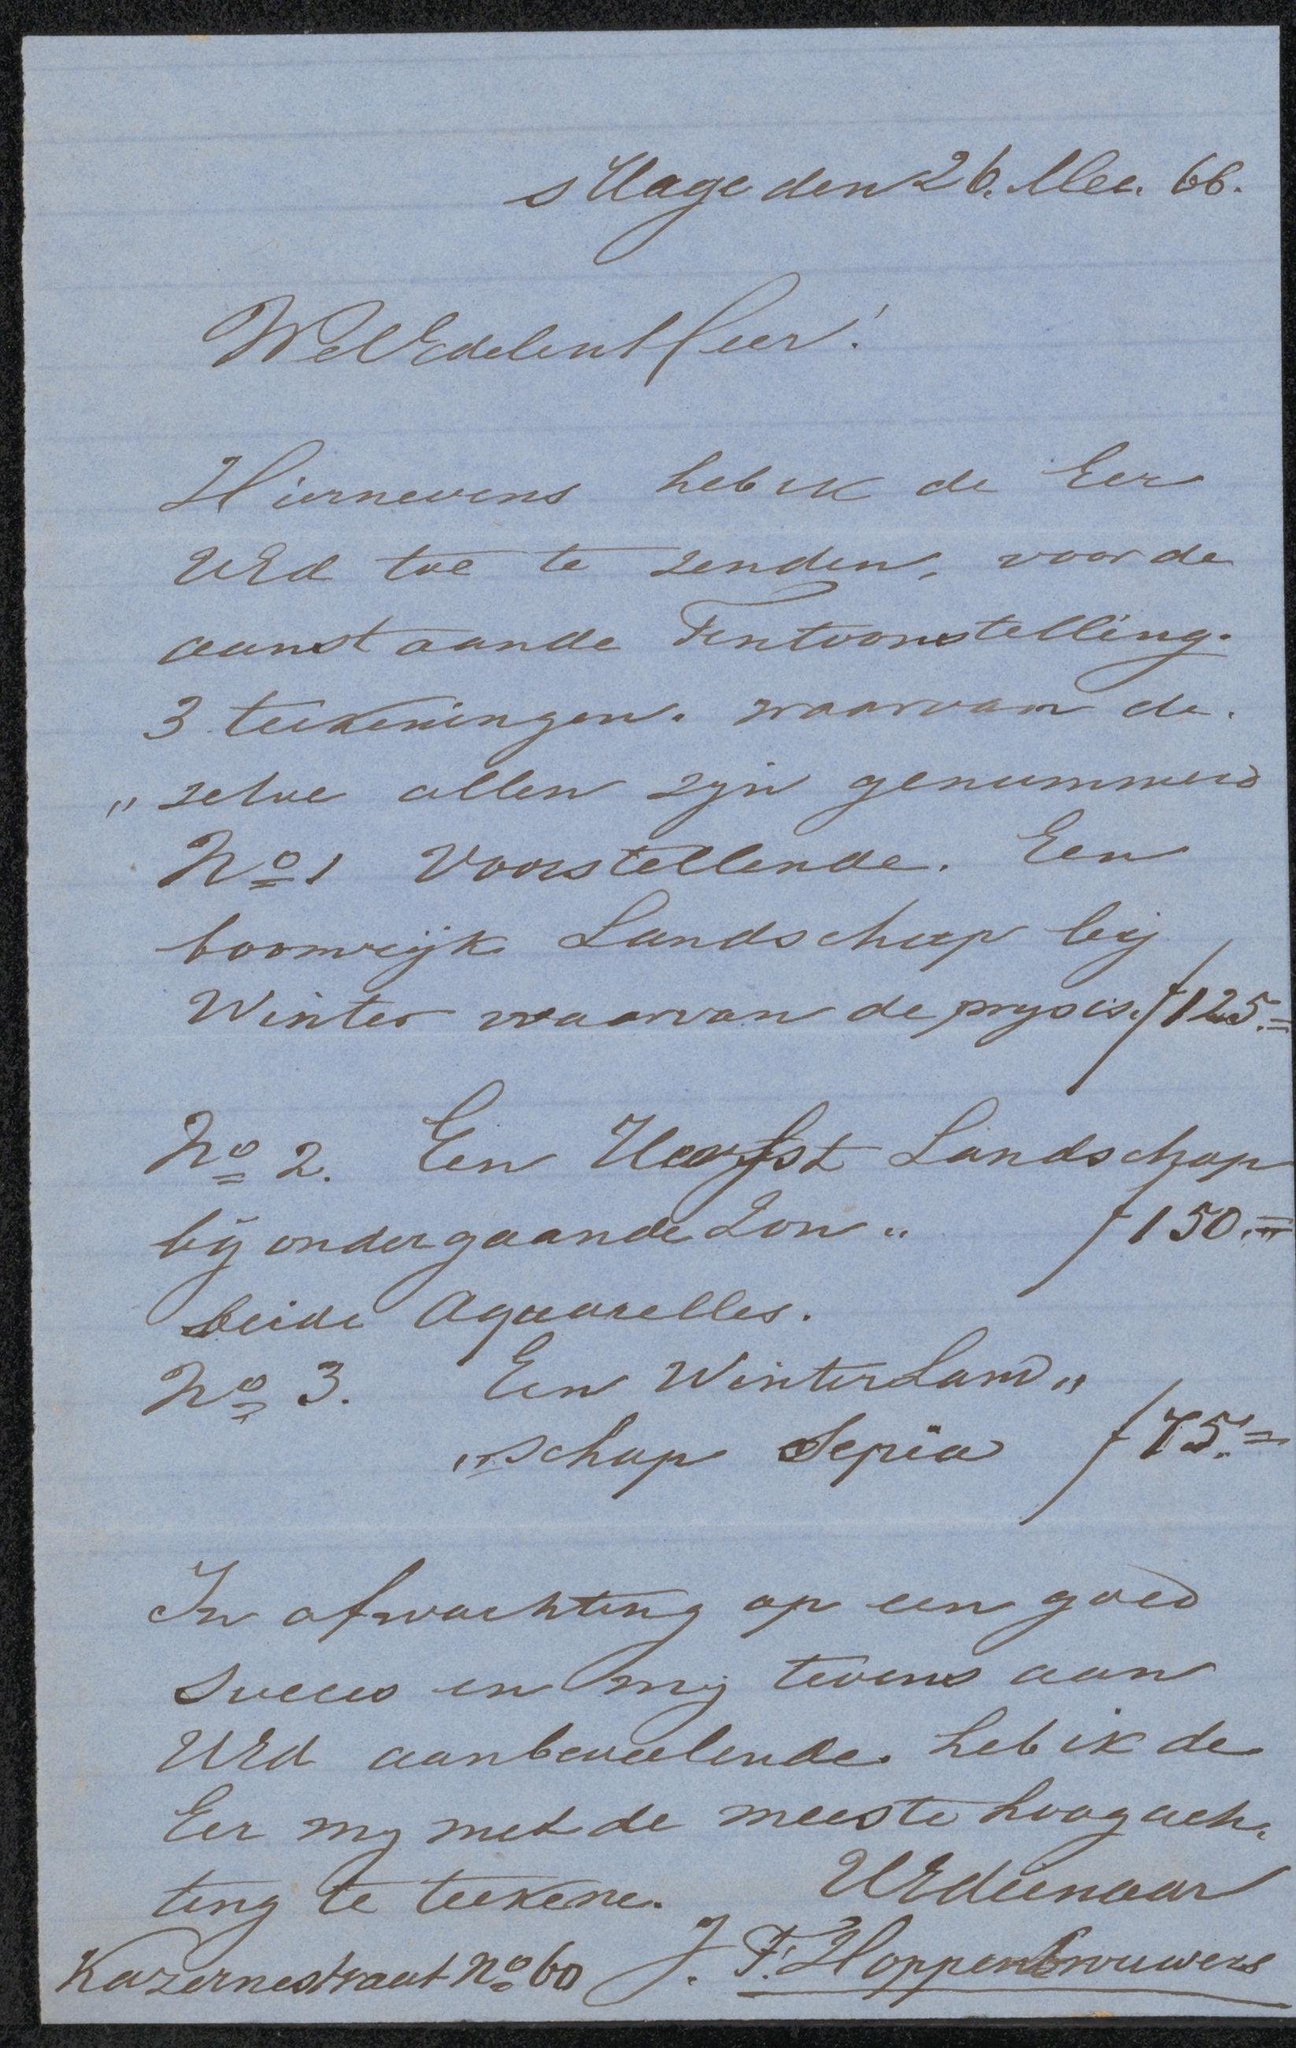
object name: letter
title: Brief aan anoniem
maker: johannes franciscus hoppenbrouwers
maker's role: draughtsman, painter, print maker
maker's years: 1819-1866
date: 1866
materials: ink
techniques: pen, writing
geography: the hague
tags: drawing, exhibition ~ art, money